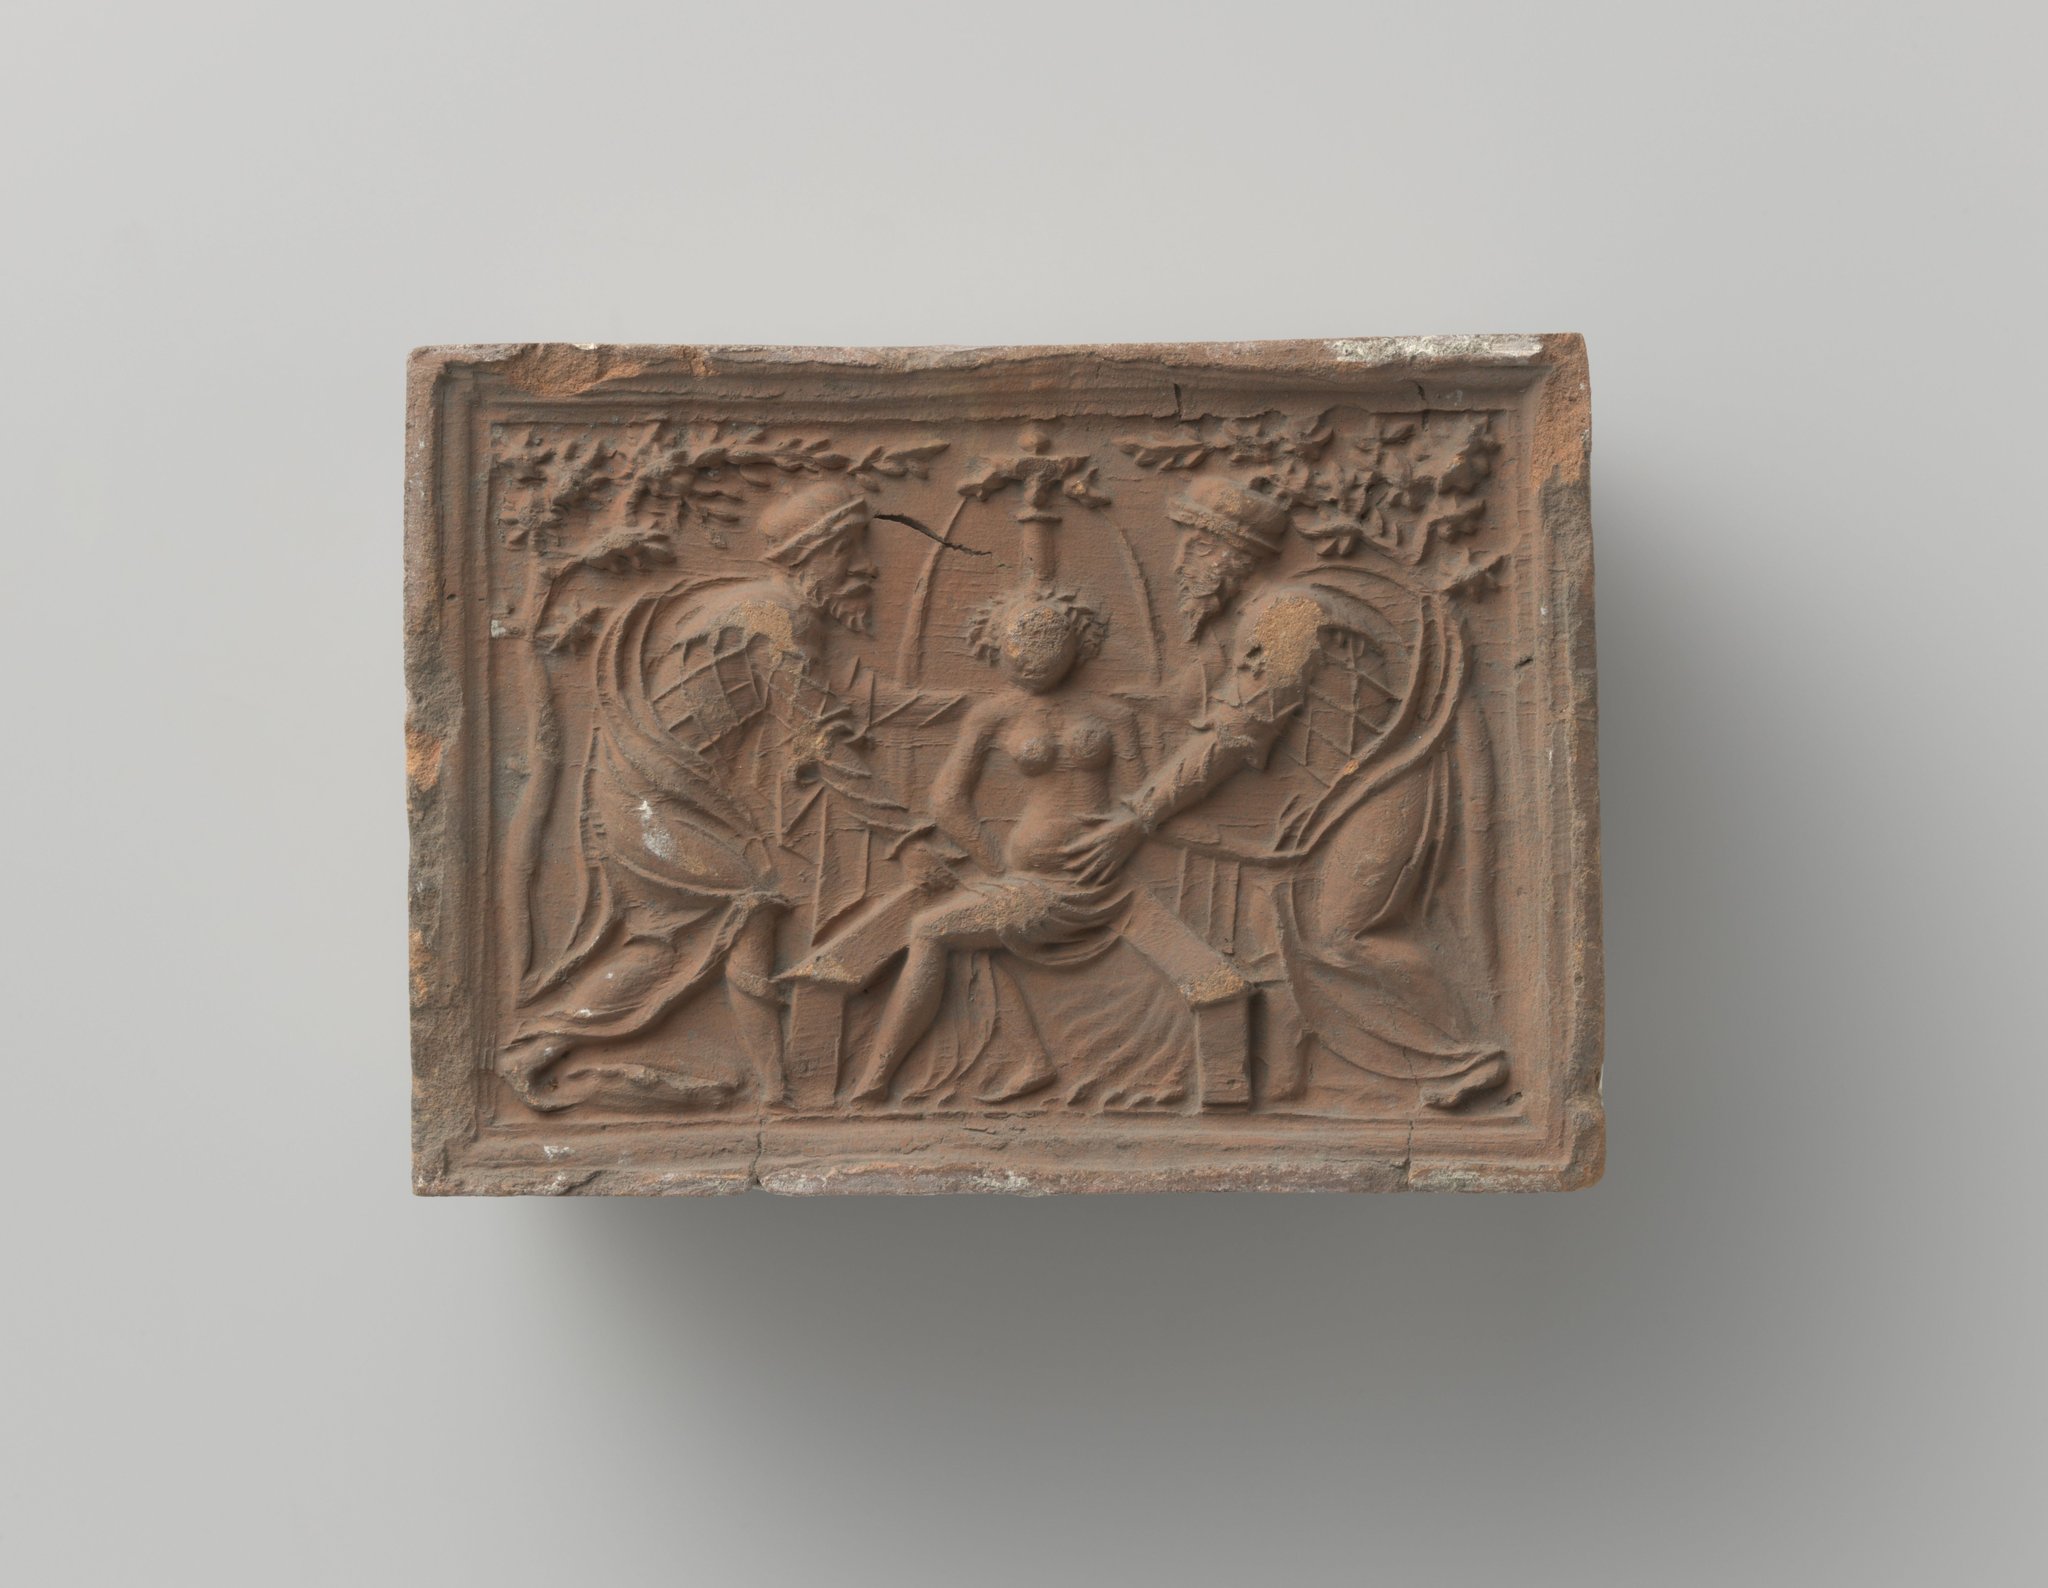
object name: hearthstone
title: Haardsteen met een voorstelling van Suzanna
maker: Anonymous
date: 1499-1699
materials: earthenware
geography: southern netherlands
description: Haardsteen met een voorstelling van Suzanna.